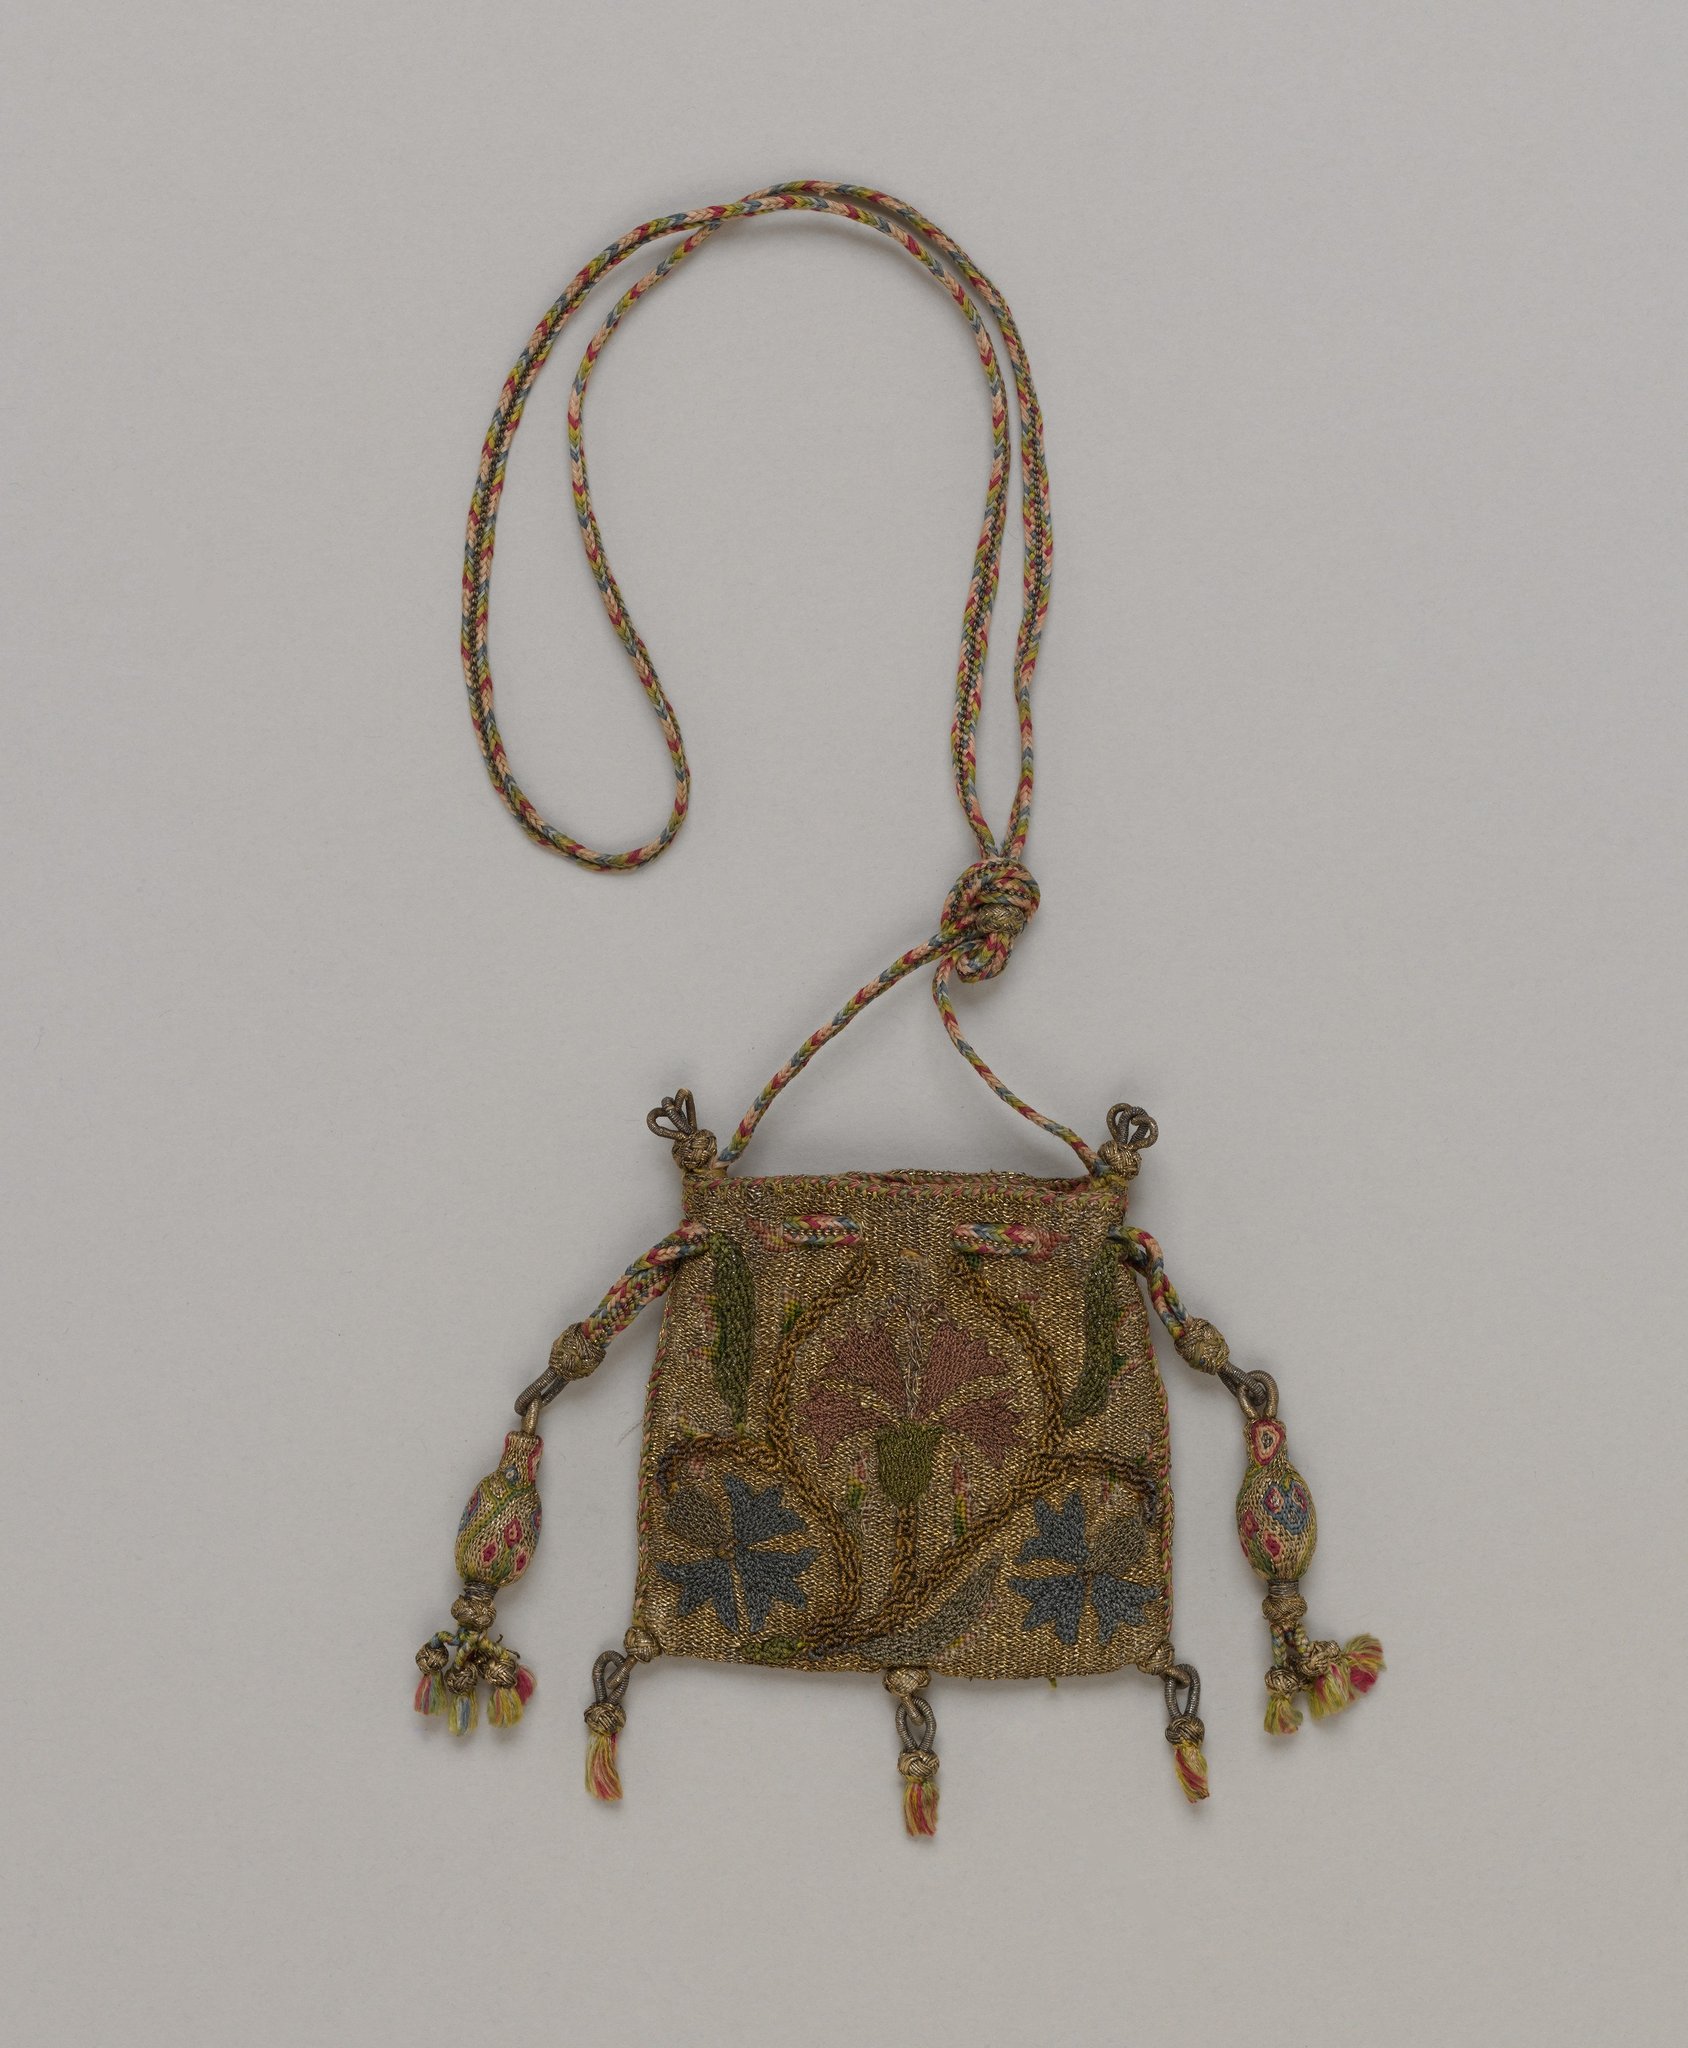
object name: purse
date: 1601-1633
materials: canvas, metal thread, silk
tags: flowers